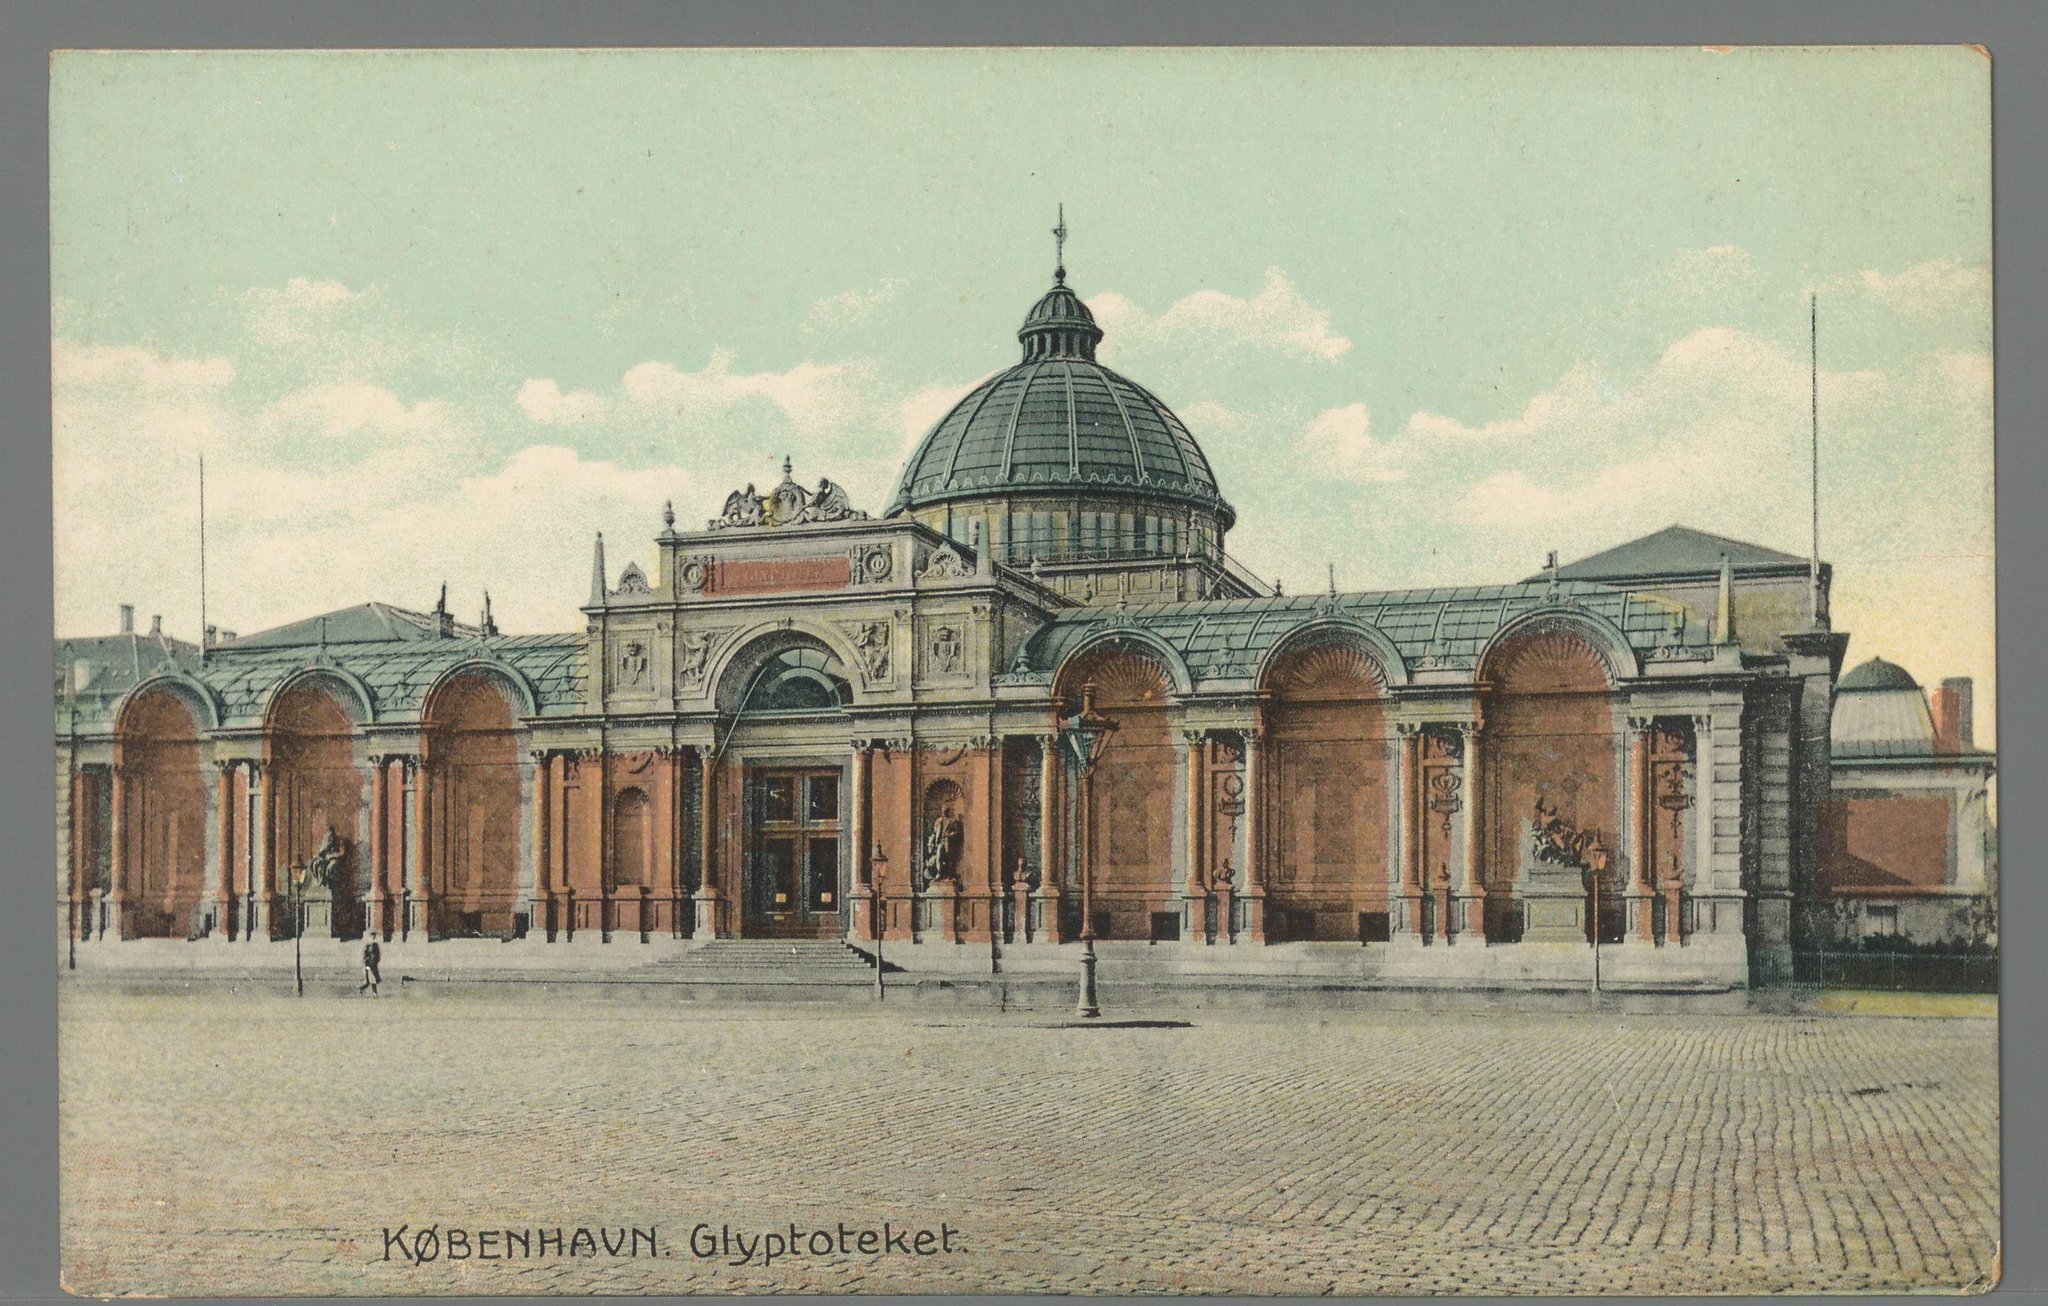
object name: ansichtkaart, prentbriefkaart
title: København. Glyptoteket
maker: Anonymous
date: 1906-1920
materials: cardboard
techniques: photograph, lithograph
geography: copenhagen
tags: permanent exhibition, museum, square, place, circus, etc. (+ city(-scape) with figures, staffage)